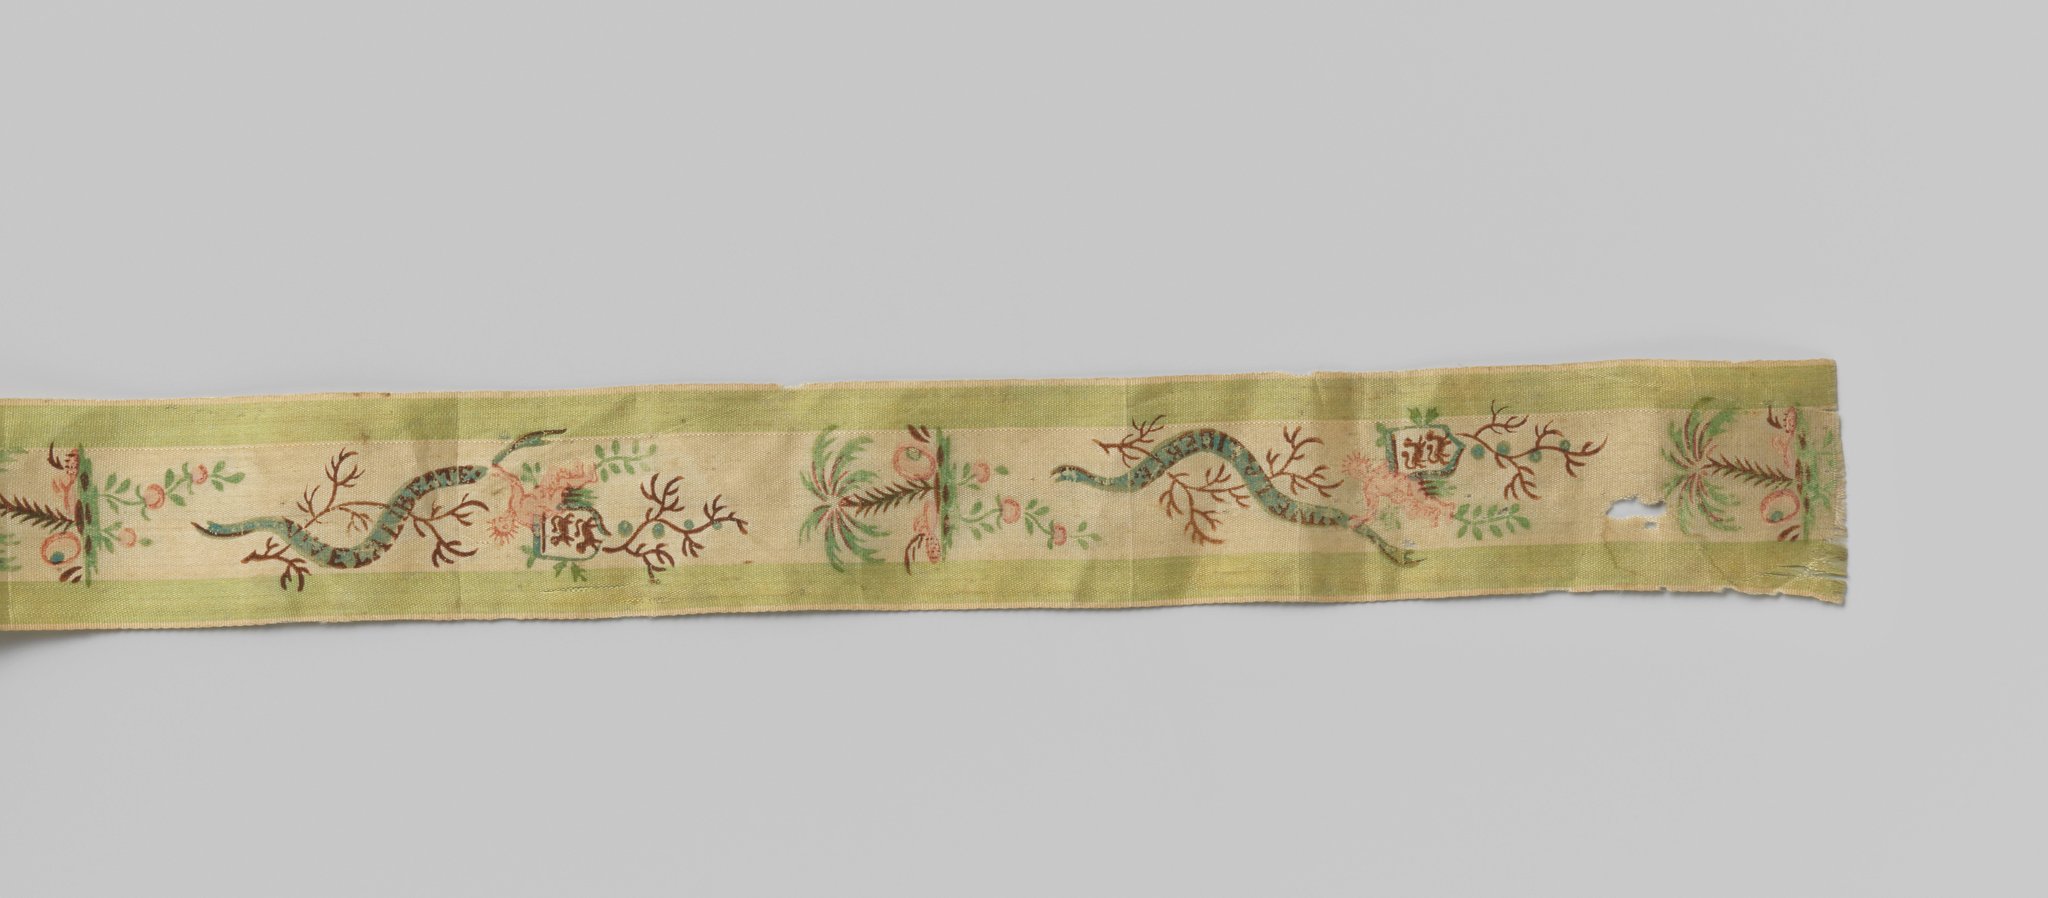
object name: ribbon material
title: Patriottenlint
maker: Anonymous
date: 1750-1800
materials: silk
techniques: printing, weave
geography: netherlands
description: Lint met lichtgroene banen aan de randen en witte baan met motieven in het midden. Palmboom met aan de ene kant een hoed en aan de andere een ovaal schild en een naakte mannefiguur met een schild waarop twee leeuwen, en in zijn opgeheven hand een blauwe band met het opschrift: VIVE LA LIBERTE (6 x herhaald). Het geheel op plantmotieven.